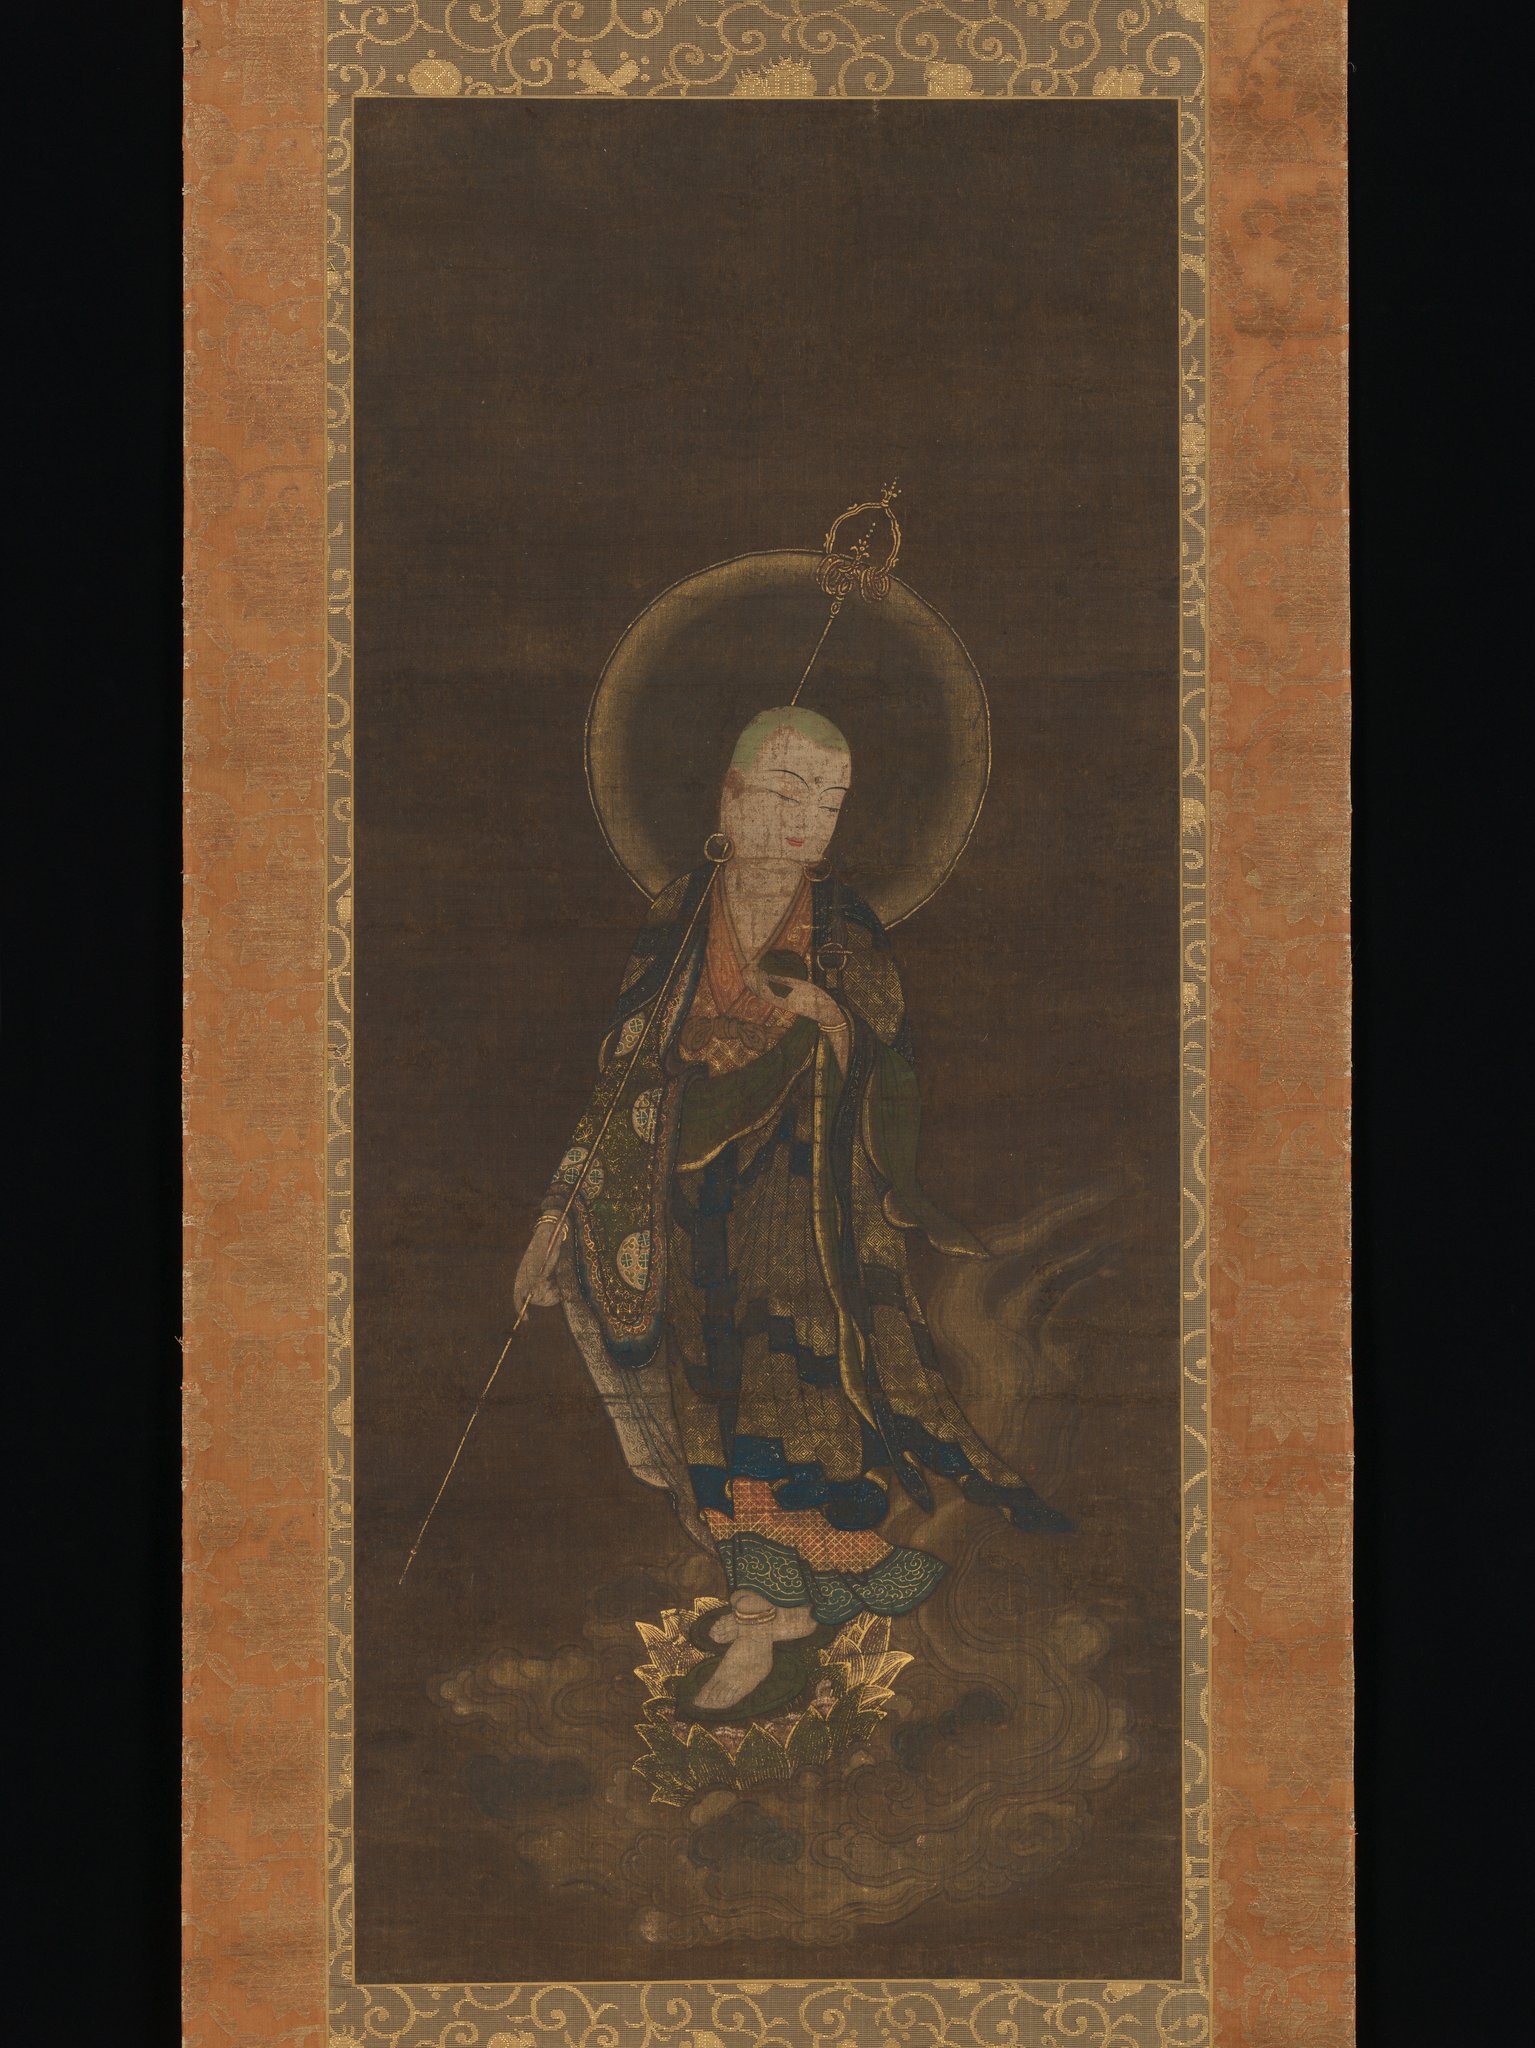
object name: hanging scroll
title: The Bodhisattva Jizō “Looking Back”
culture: japanese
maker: unidentified artist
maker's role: artist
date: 1301-1400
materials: gold, gold paint, ink, silk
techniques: cutting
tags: buddhism,bodhisattvas